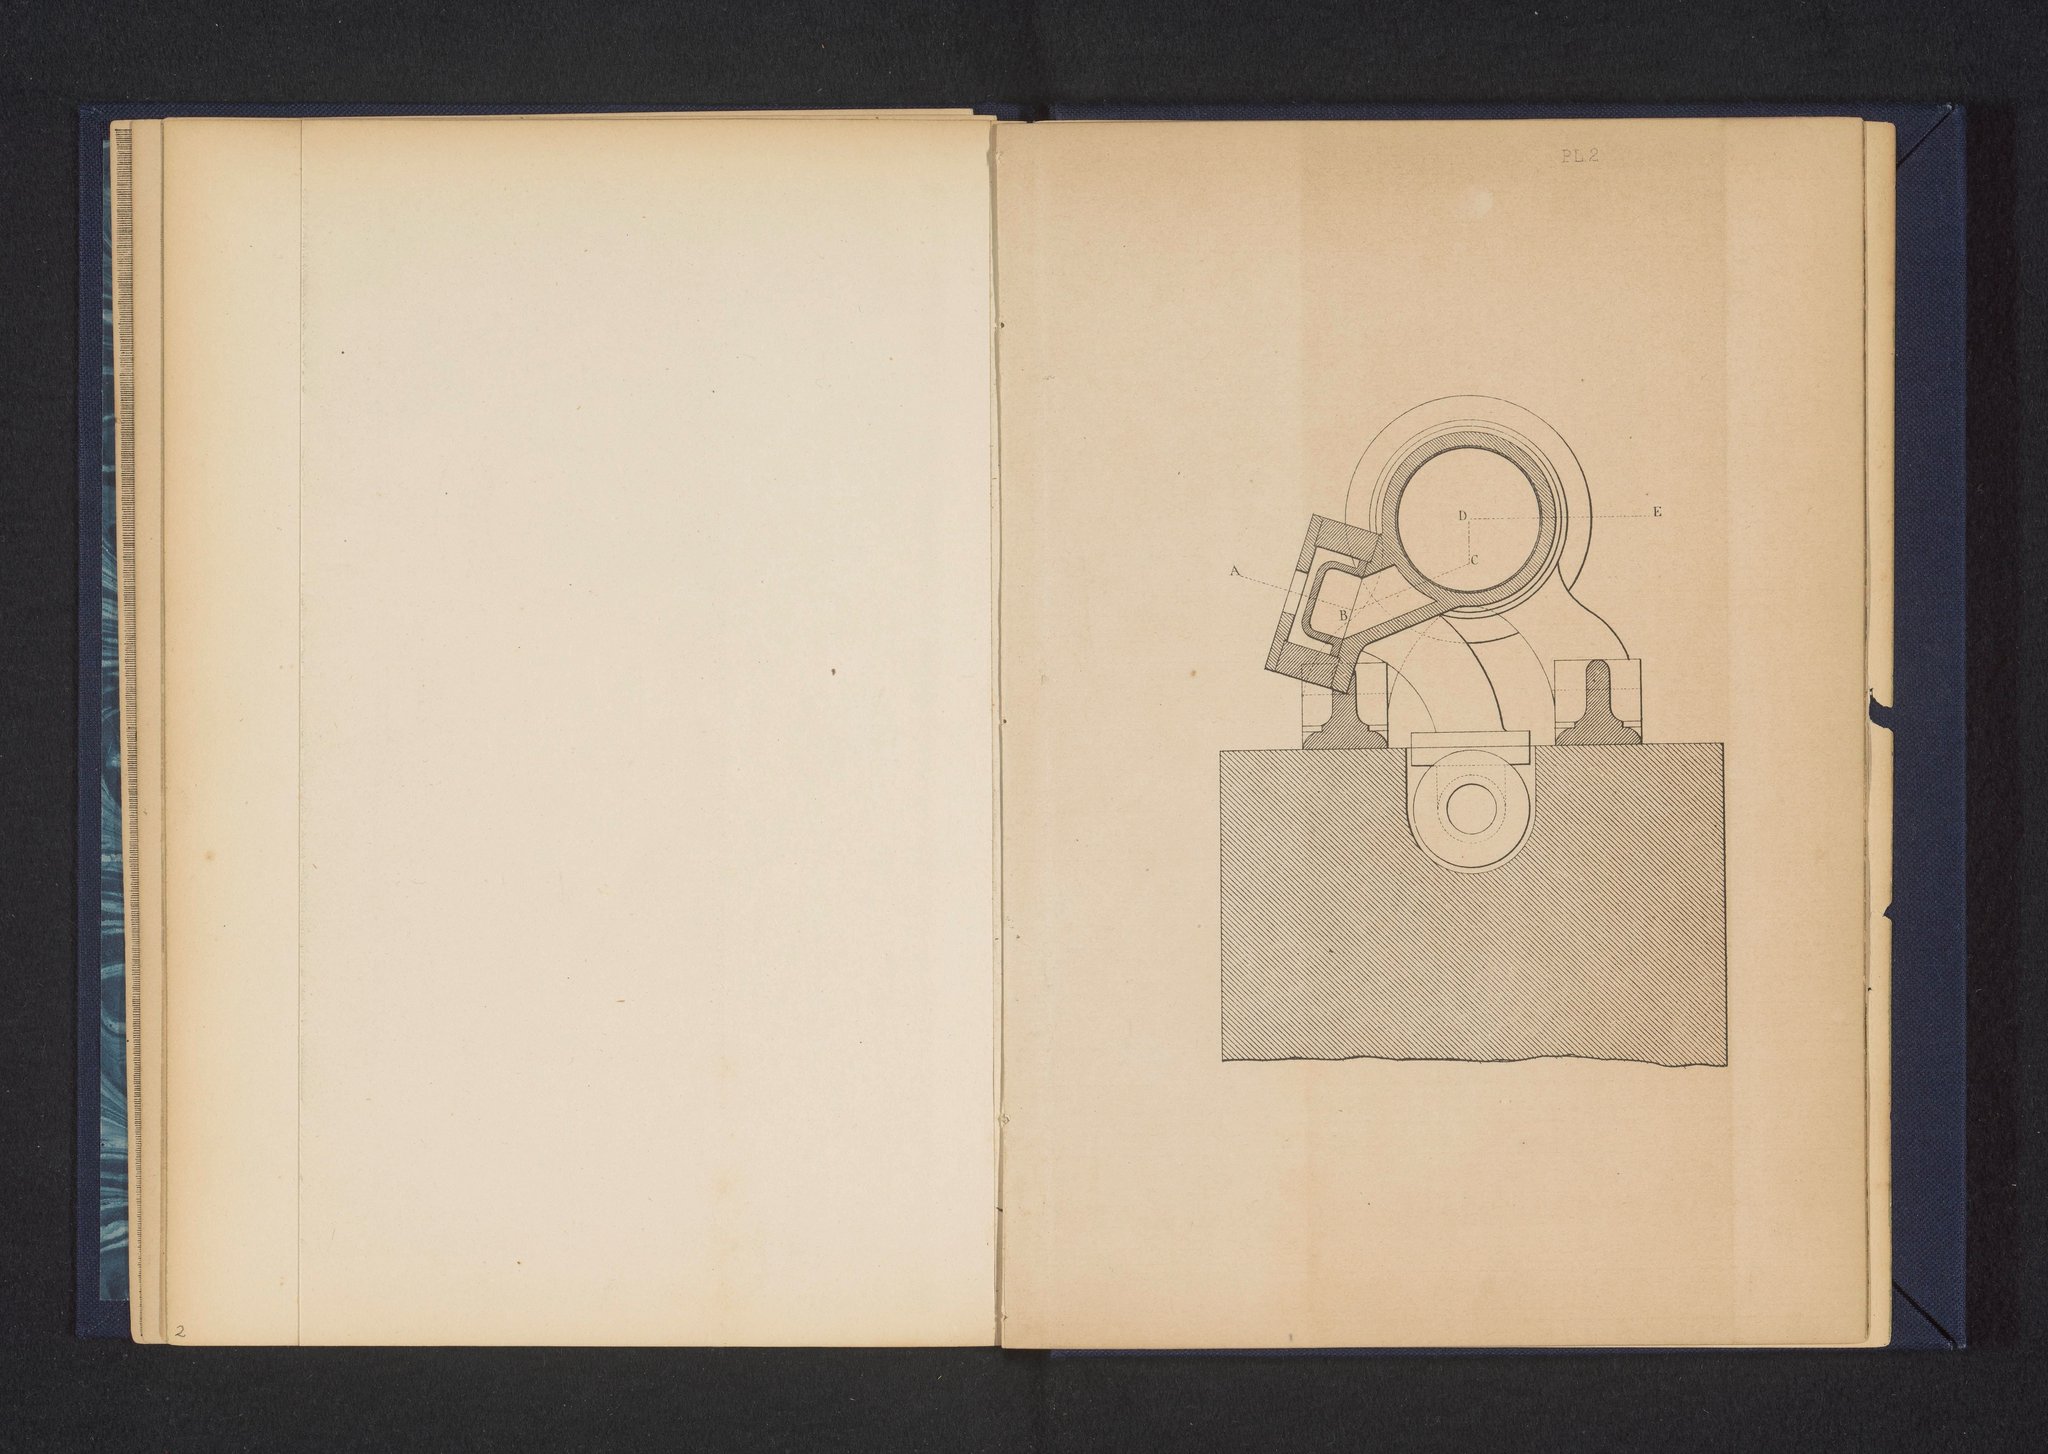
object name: reproduction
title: Reproductie van een modeltekening van delen van een machine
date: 1868-1873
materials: paper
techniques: photolithography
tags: parts of machines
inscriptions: number: ‘Pl. 2’